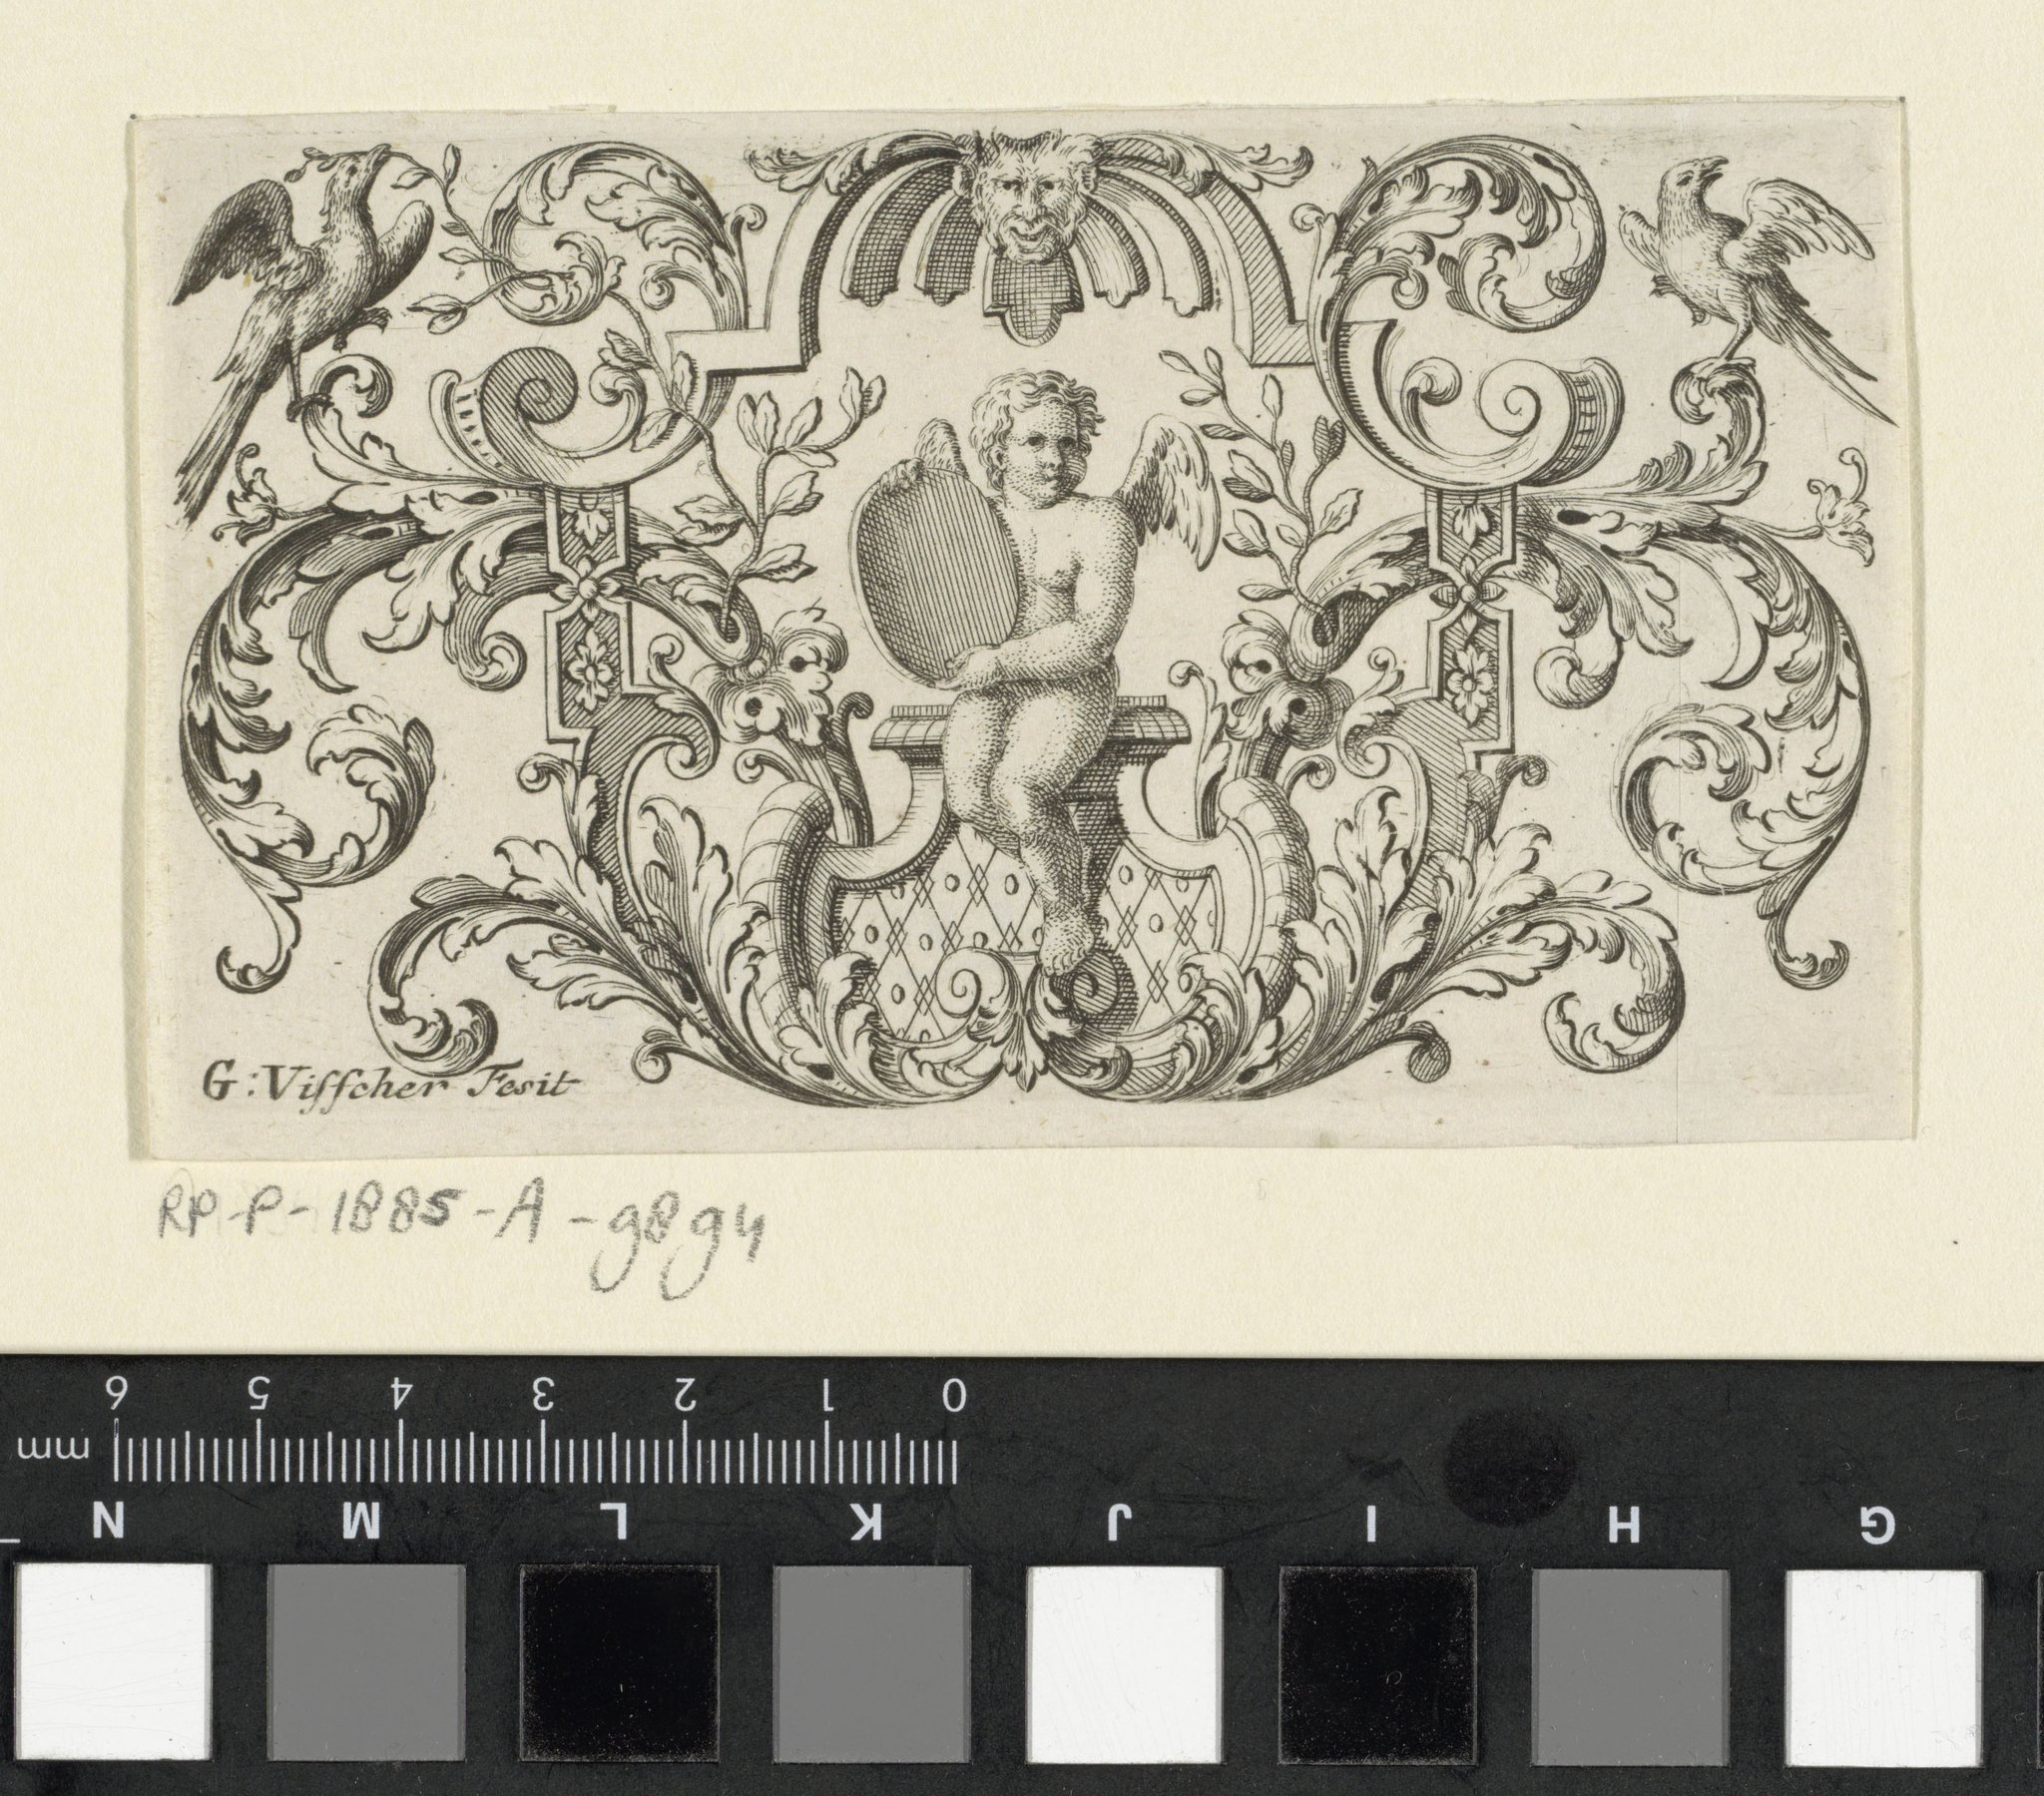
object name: print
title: Putto met rond bord in de handen ten midden van bladranken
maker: gerrit visscher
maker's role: print maker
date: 1690-1710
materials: paper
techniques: engraving, etching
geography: amsterdam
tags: foliage, tendrils, branches ~ ornament, cupids: 'amores', 'amoretti', 'putti'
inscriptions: collector's mark: Lugt 2228